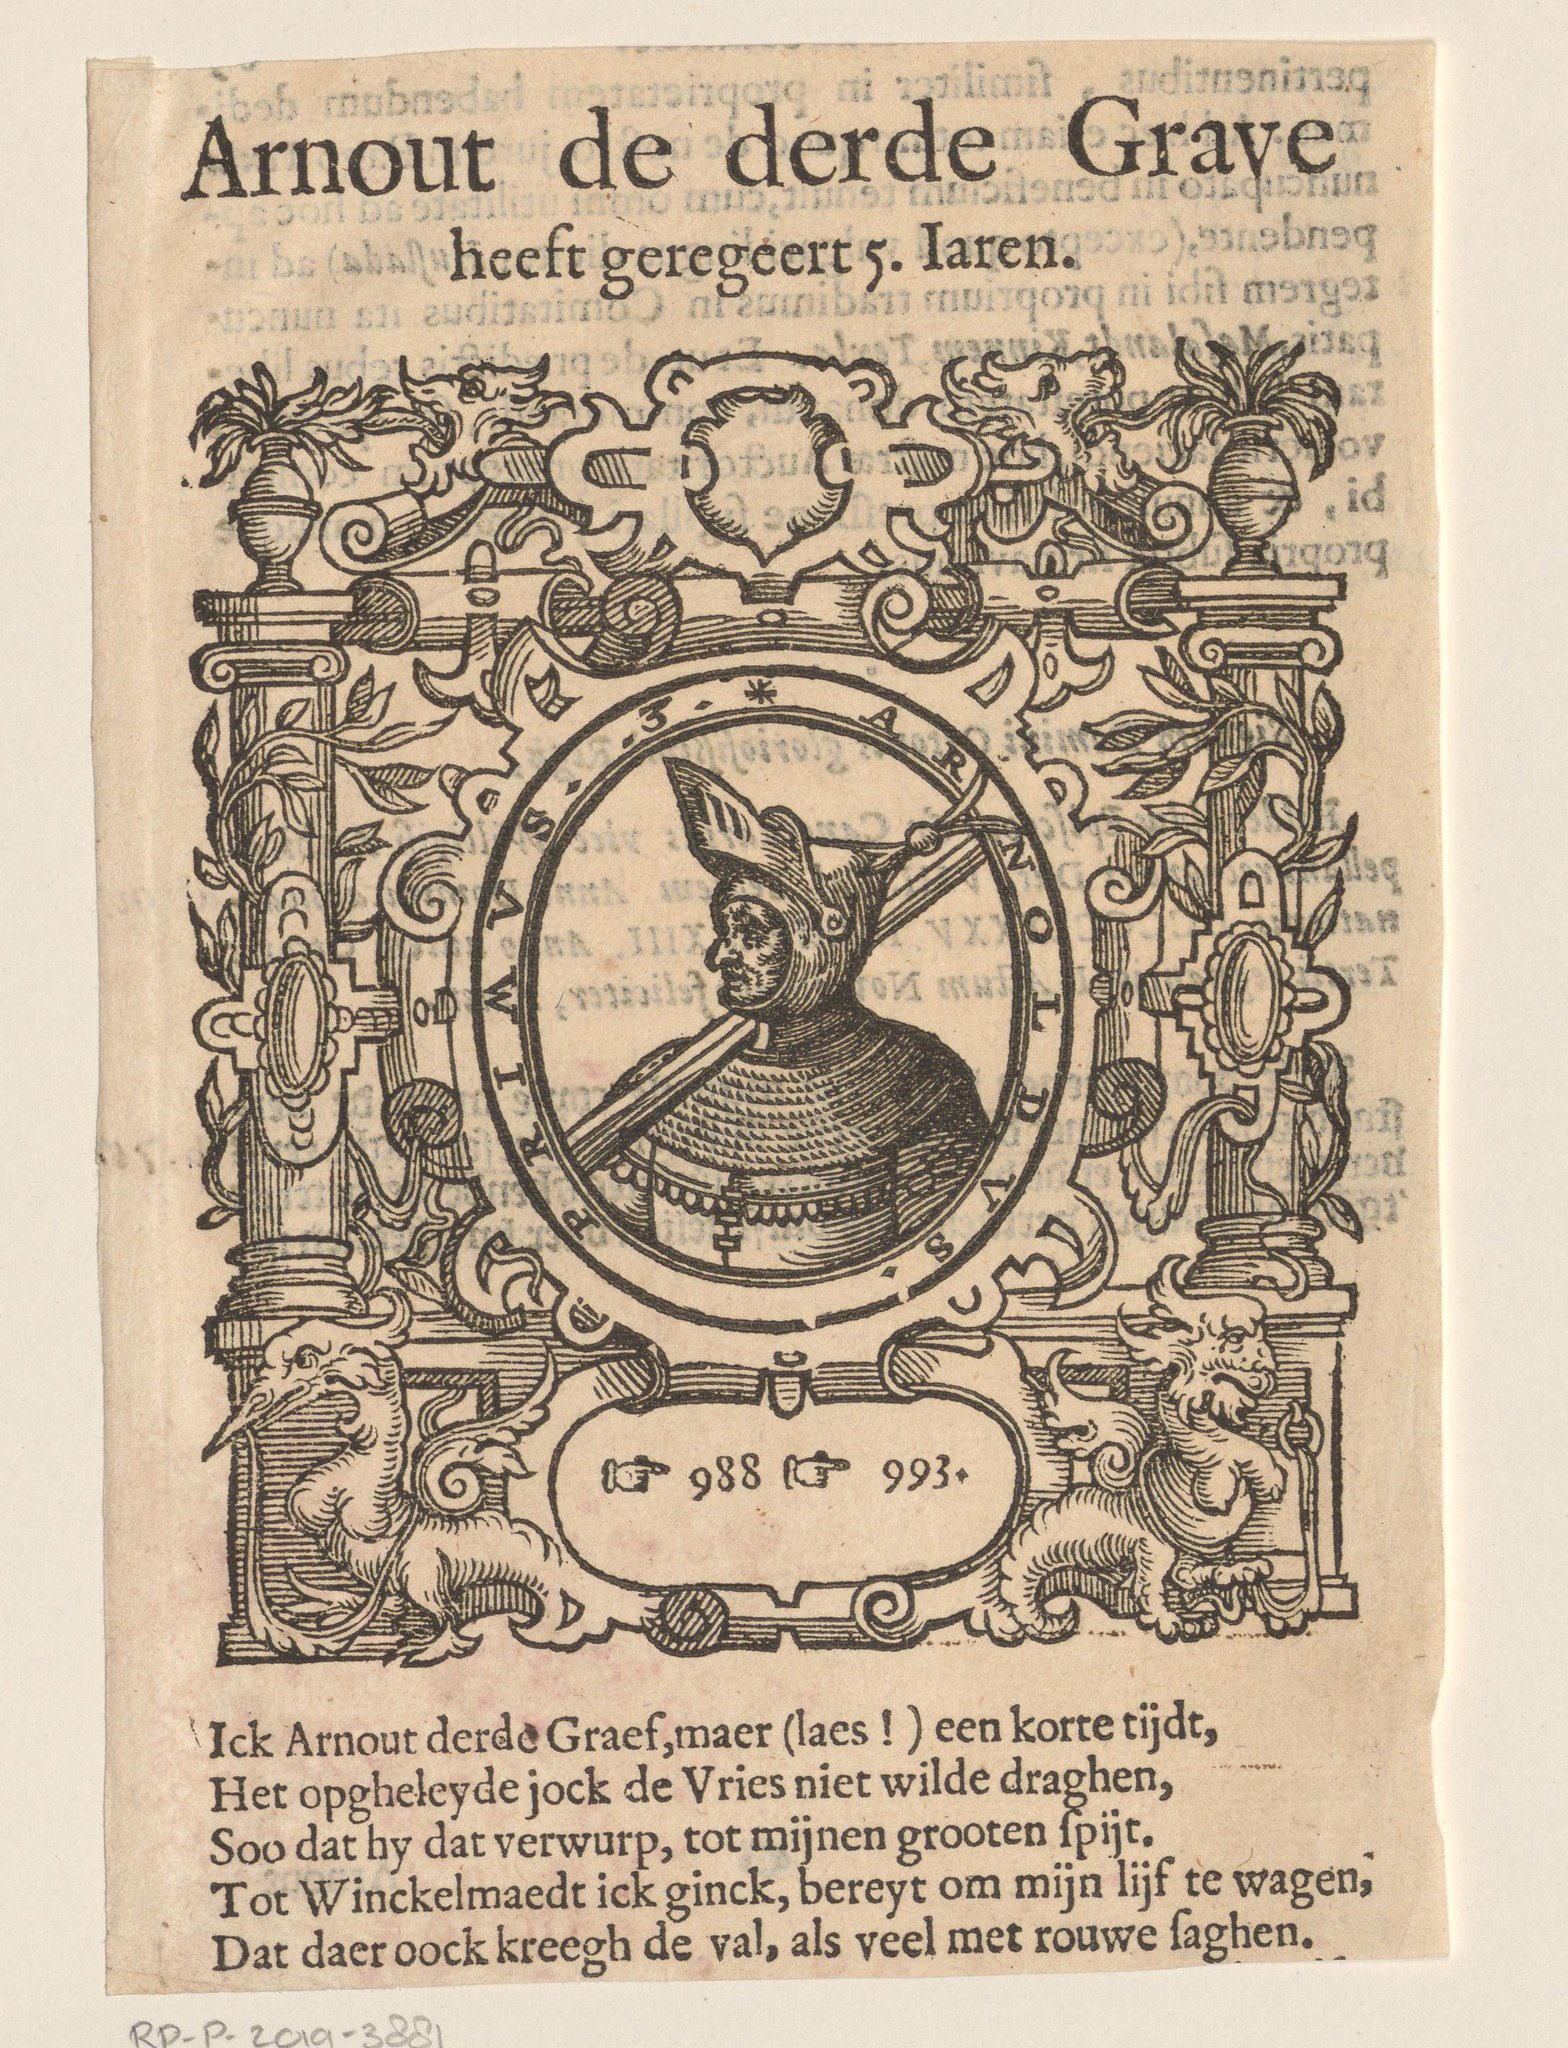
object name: print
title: Portret van Arnulf, graaf van Holland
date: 1636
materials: paper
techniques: letterpress printing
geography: amsterdam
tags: ghent, earl, helmet, armour, historical persons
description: Prent uit: Scriverius, Petrus. Beschrivinge va n oud Batavien met de antiquiteyten van dien. Amsterdam: Jan Evertsz. Cloppenburgh, 1736.